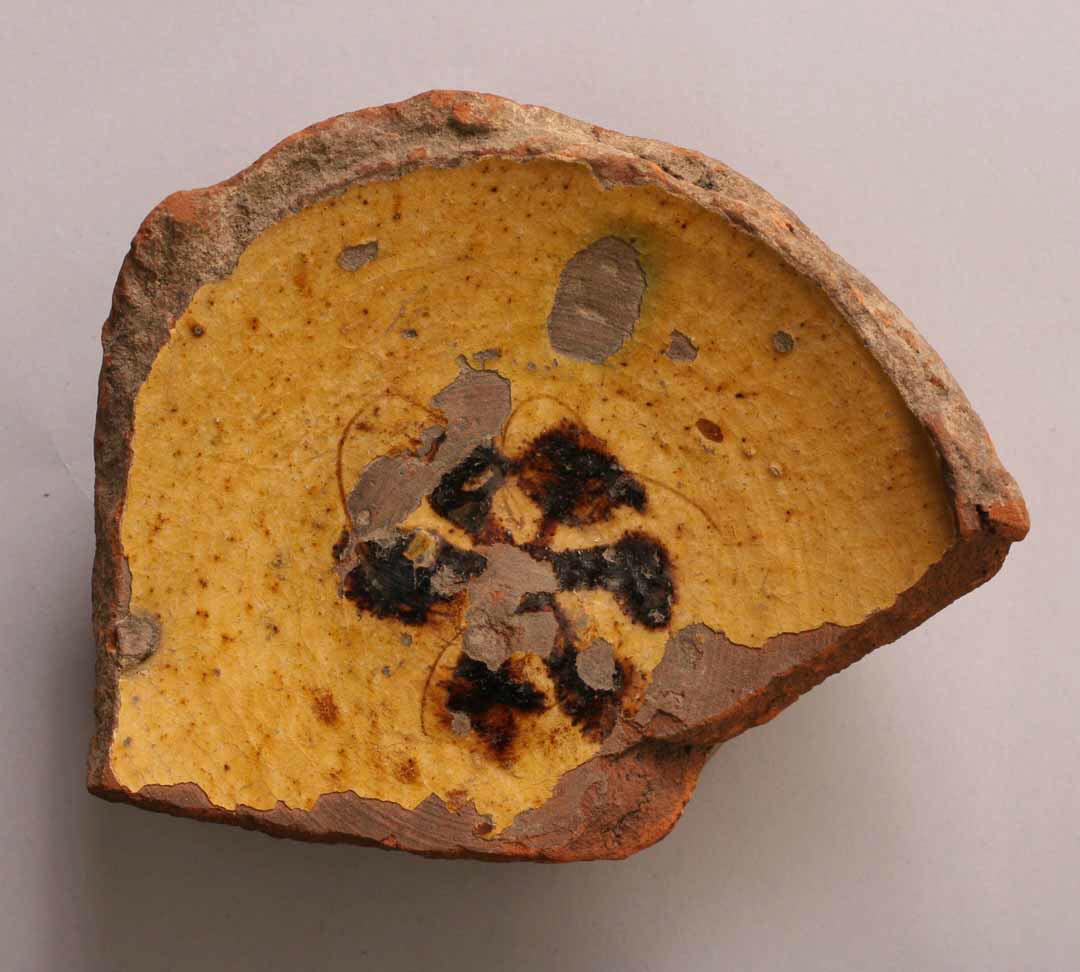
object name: fragment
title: Fragment of a Bowl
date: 1301-1500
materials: earthenware, glaze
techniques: coloring, incising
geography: egypt